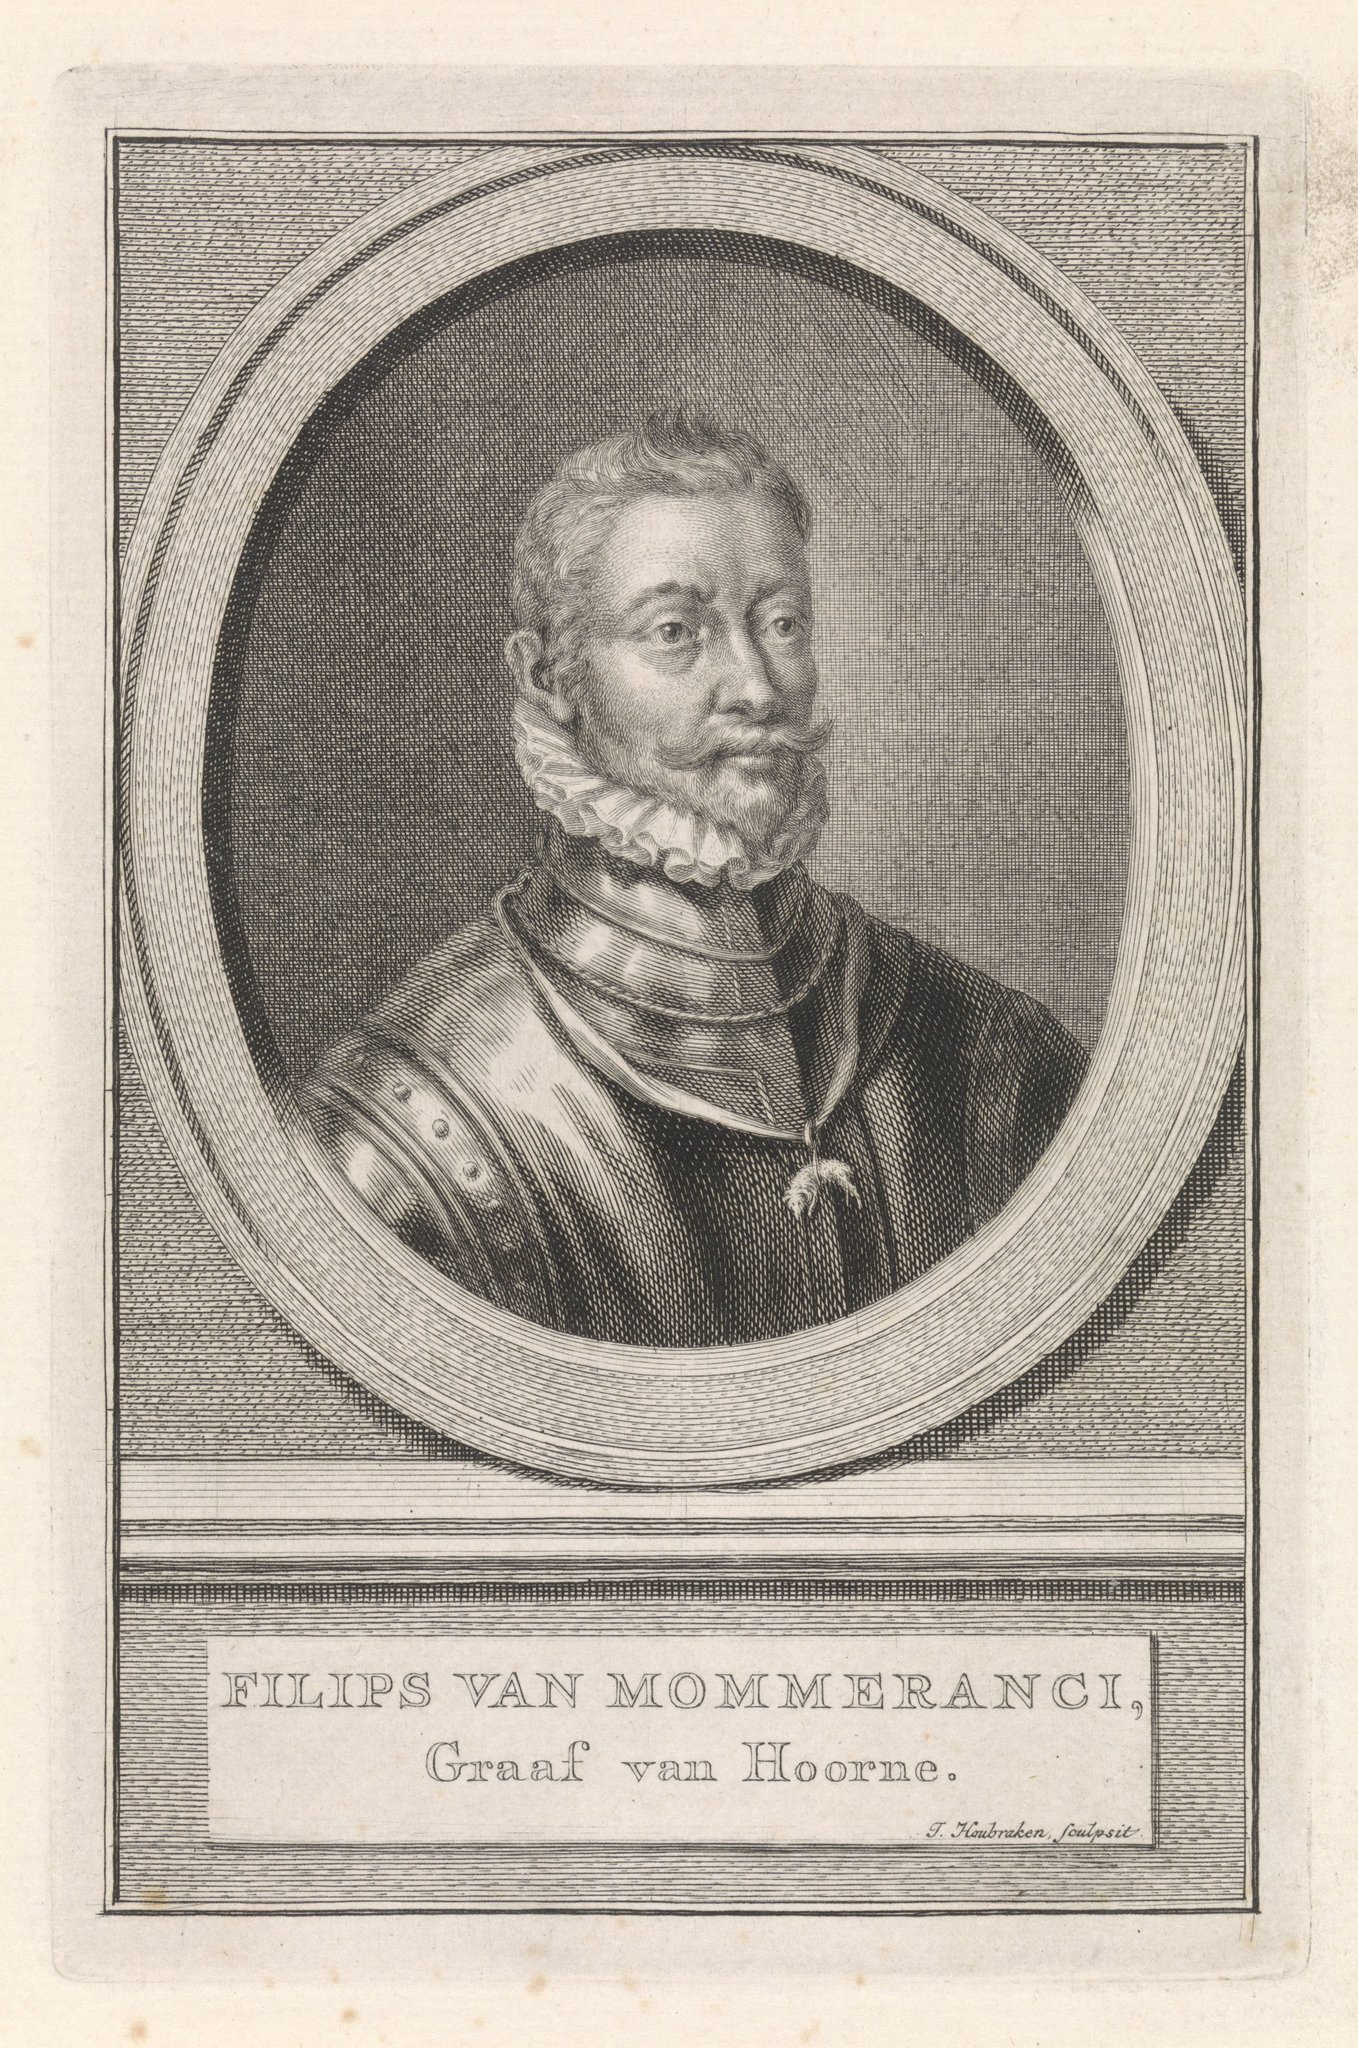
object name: print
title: Portret van Philips van Montmorency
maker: jacob houbraken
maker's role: draughtsman, print maker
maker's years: 1698-1780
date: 1708-1780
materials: paper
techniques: engraving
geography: amsterdam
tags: nevele, admiraal, stadhouder, staatsman, philips van montmorency (graaf van horne)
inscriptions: collector's mark: Lugt 2228, collector's mark: Lugt 240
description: Buste naar rechts van Philips van Montmorency, graaf van Hoorne, in een ovaal. Hij is gekleed in een harnas en draagt om zijn hals het teken van de Orde van het Gulden Vlies. Het portret rust op een plint waarop zijn naam en titel in twee regels in het Nederlands.